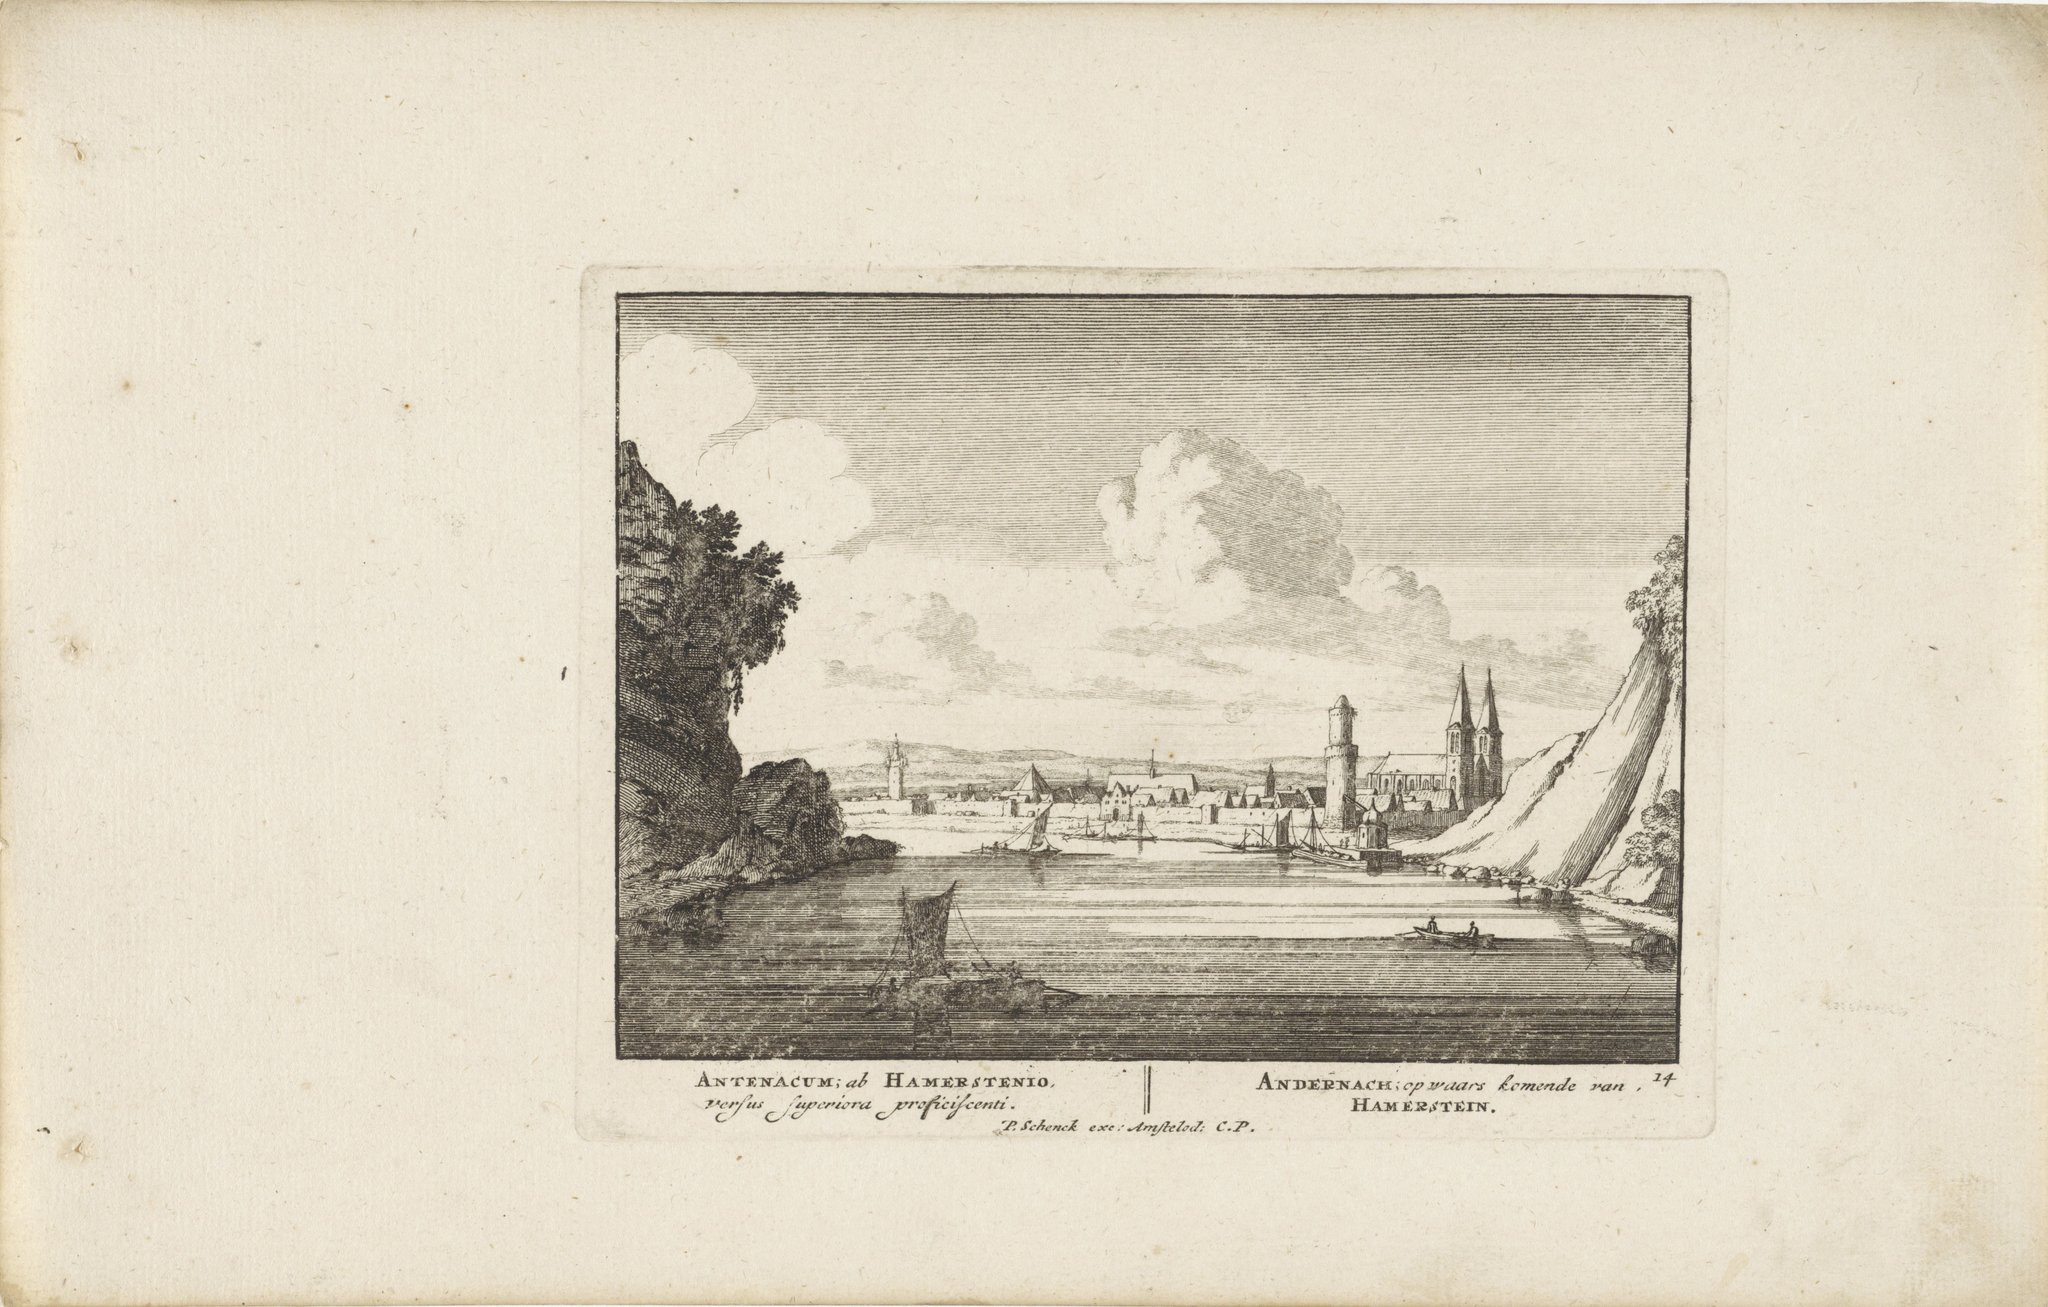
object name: print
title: Gezicht op Andernach aan de Rijn met de Bolle Toren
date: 1694-1697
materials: paper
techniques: etching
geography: amsterdam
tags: river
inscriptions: collector's mark: Lugt 2228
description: Gezicht op Andernach aan de Rijn met de Bolle Toren. Prent uit een serie van 71 prenten met Rijnlandschappen, gezichten op vorstelijke paleizen en stadsgezichten uit Den Haag en Amsterdam.